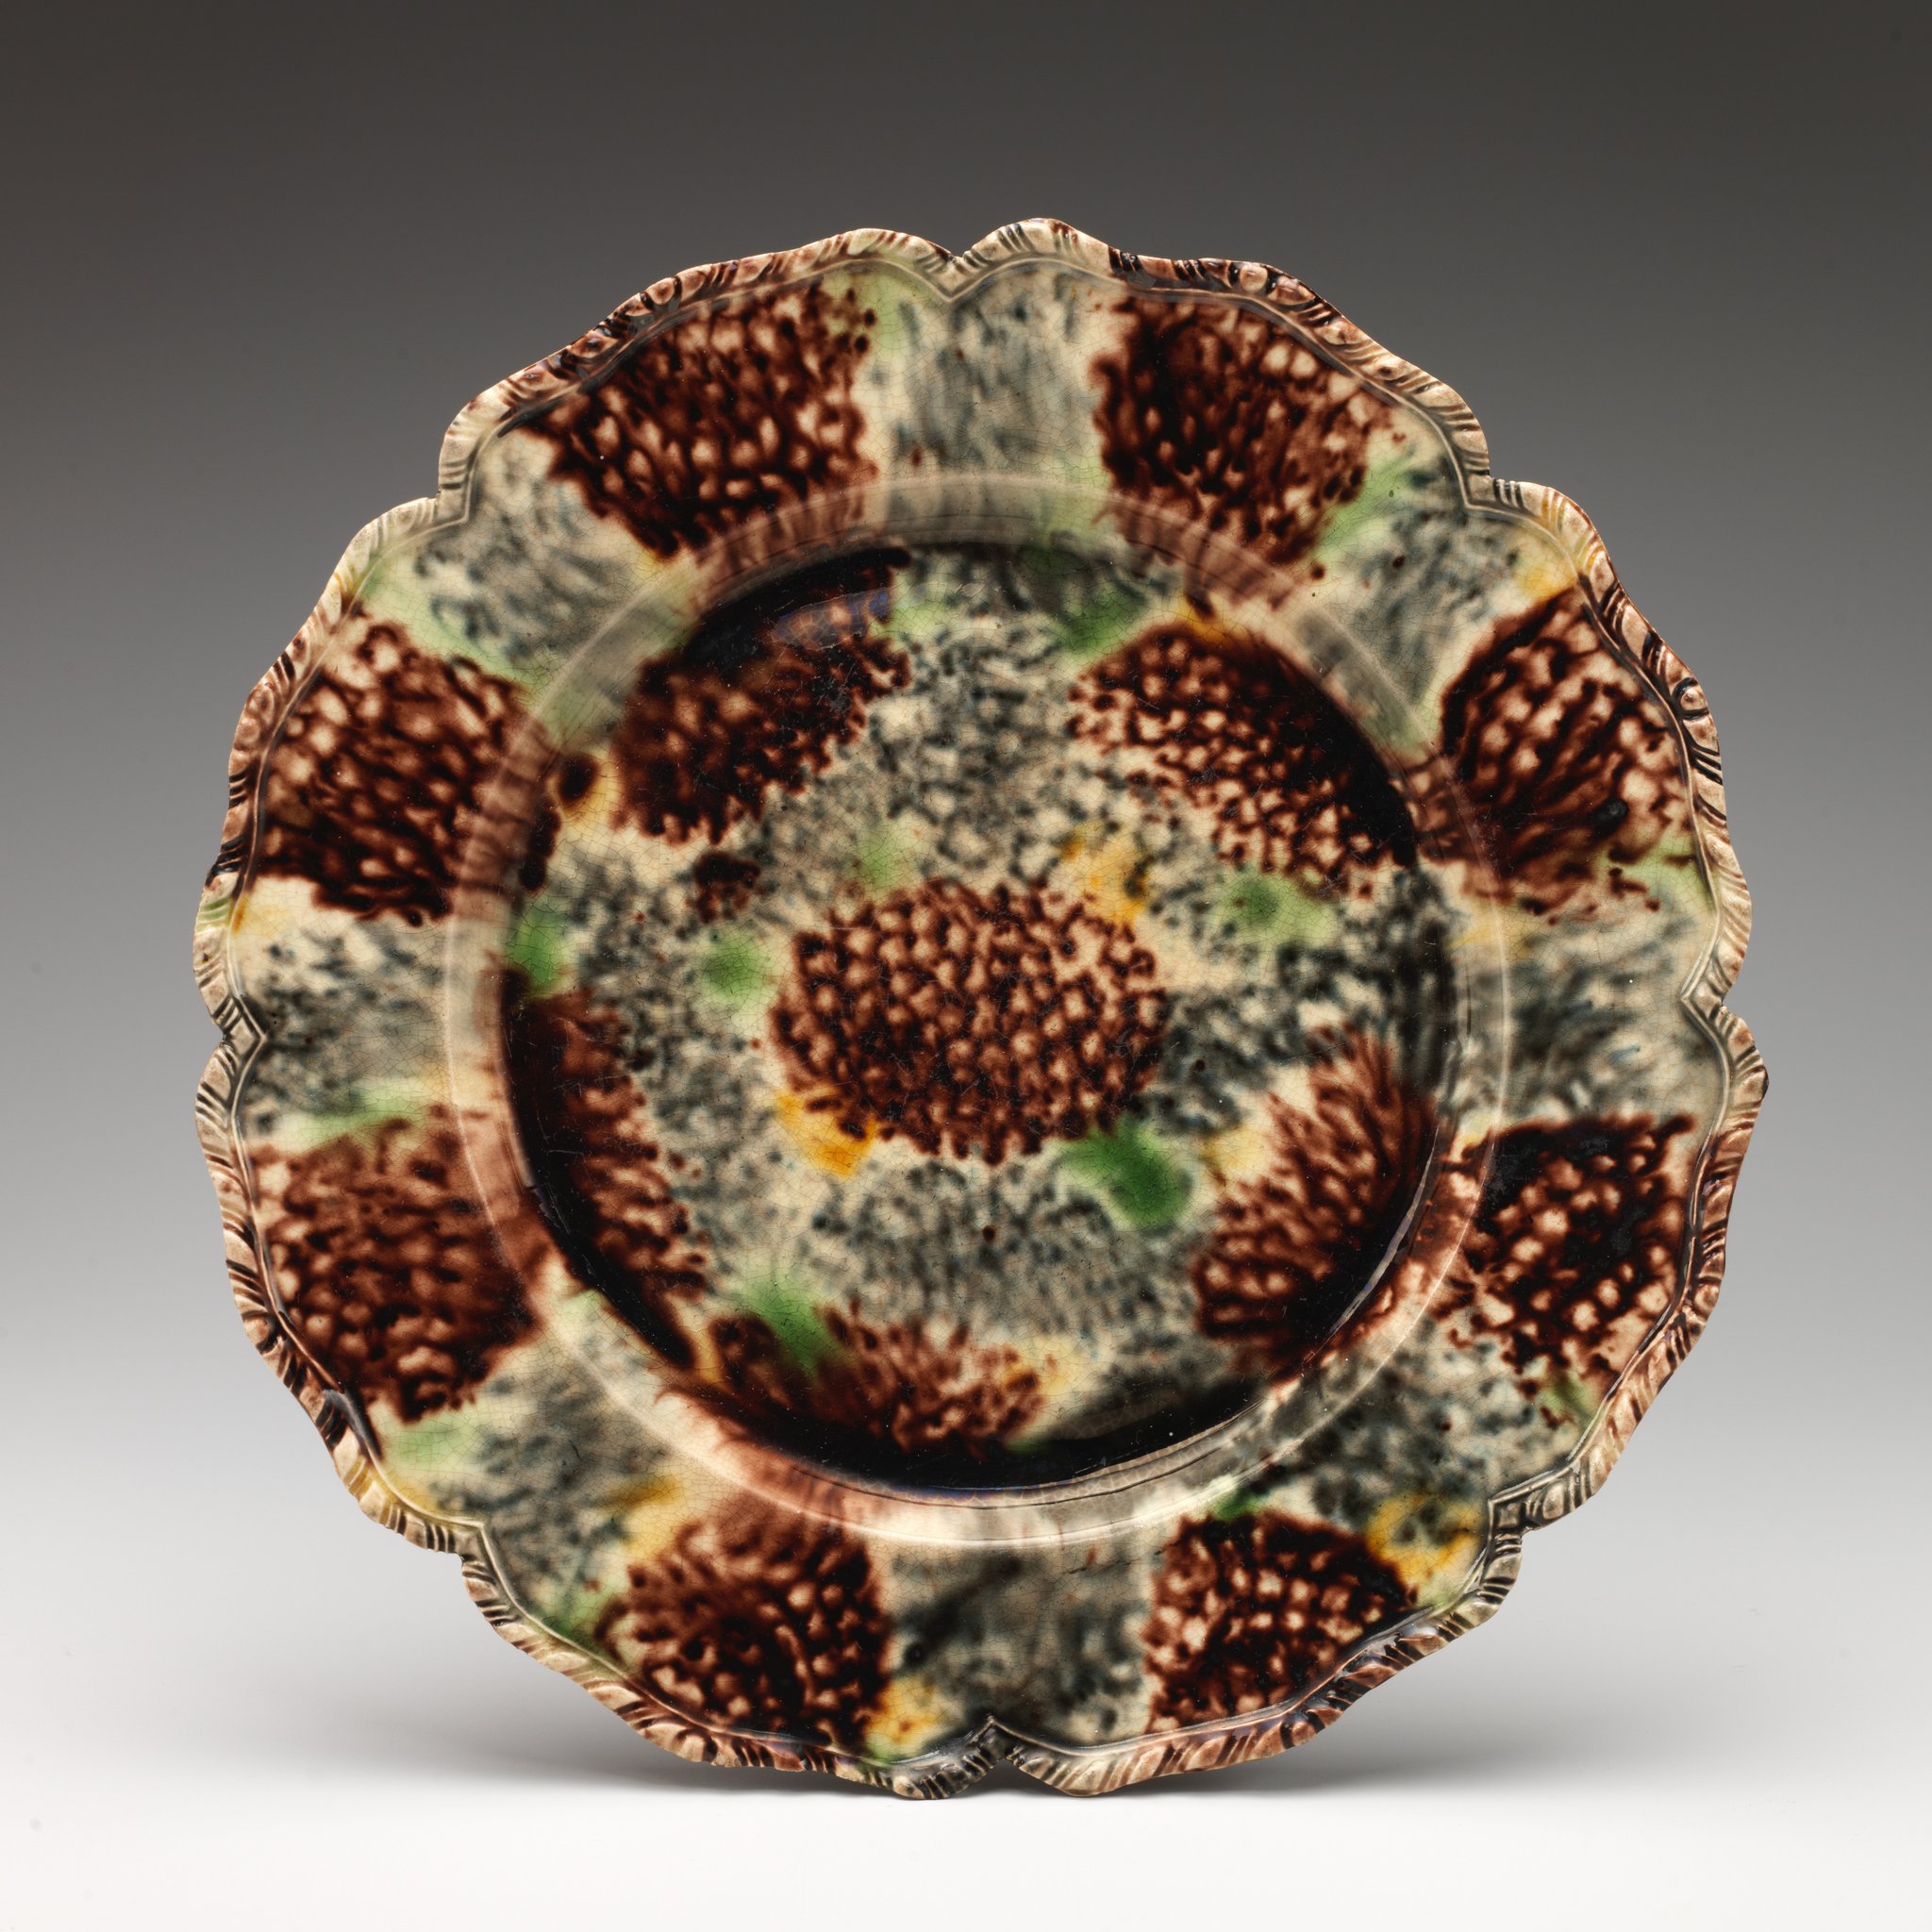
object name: plate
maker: whieldon type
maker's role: maker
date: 1750-1770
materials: earthenware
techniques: glazing